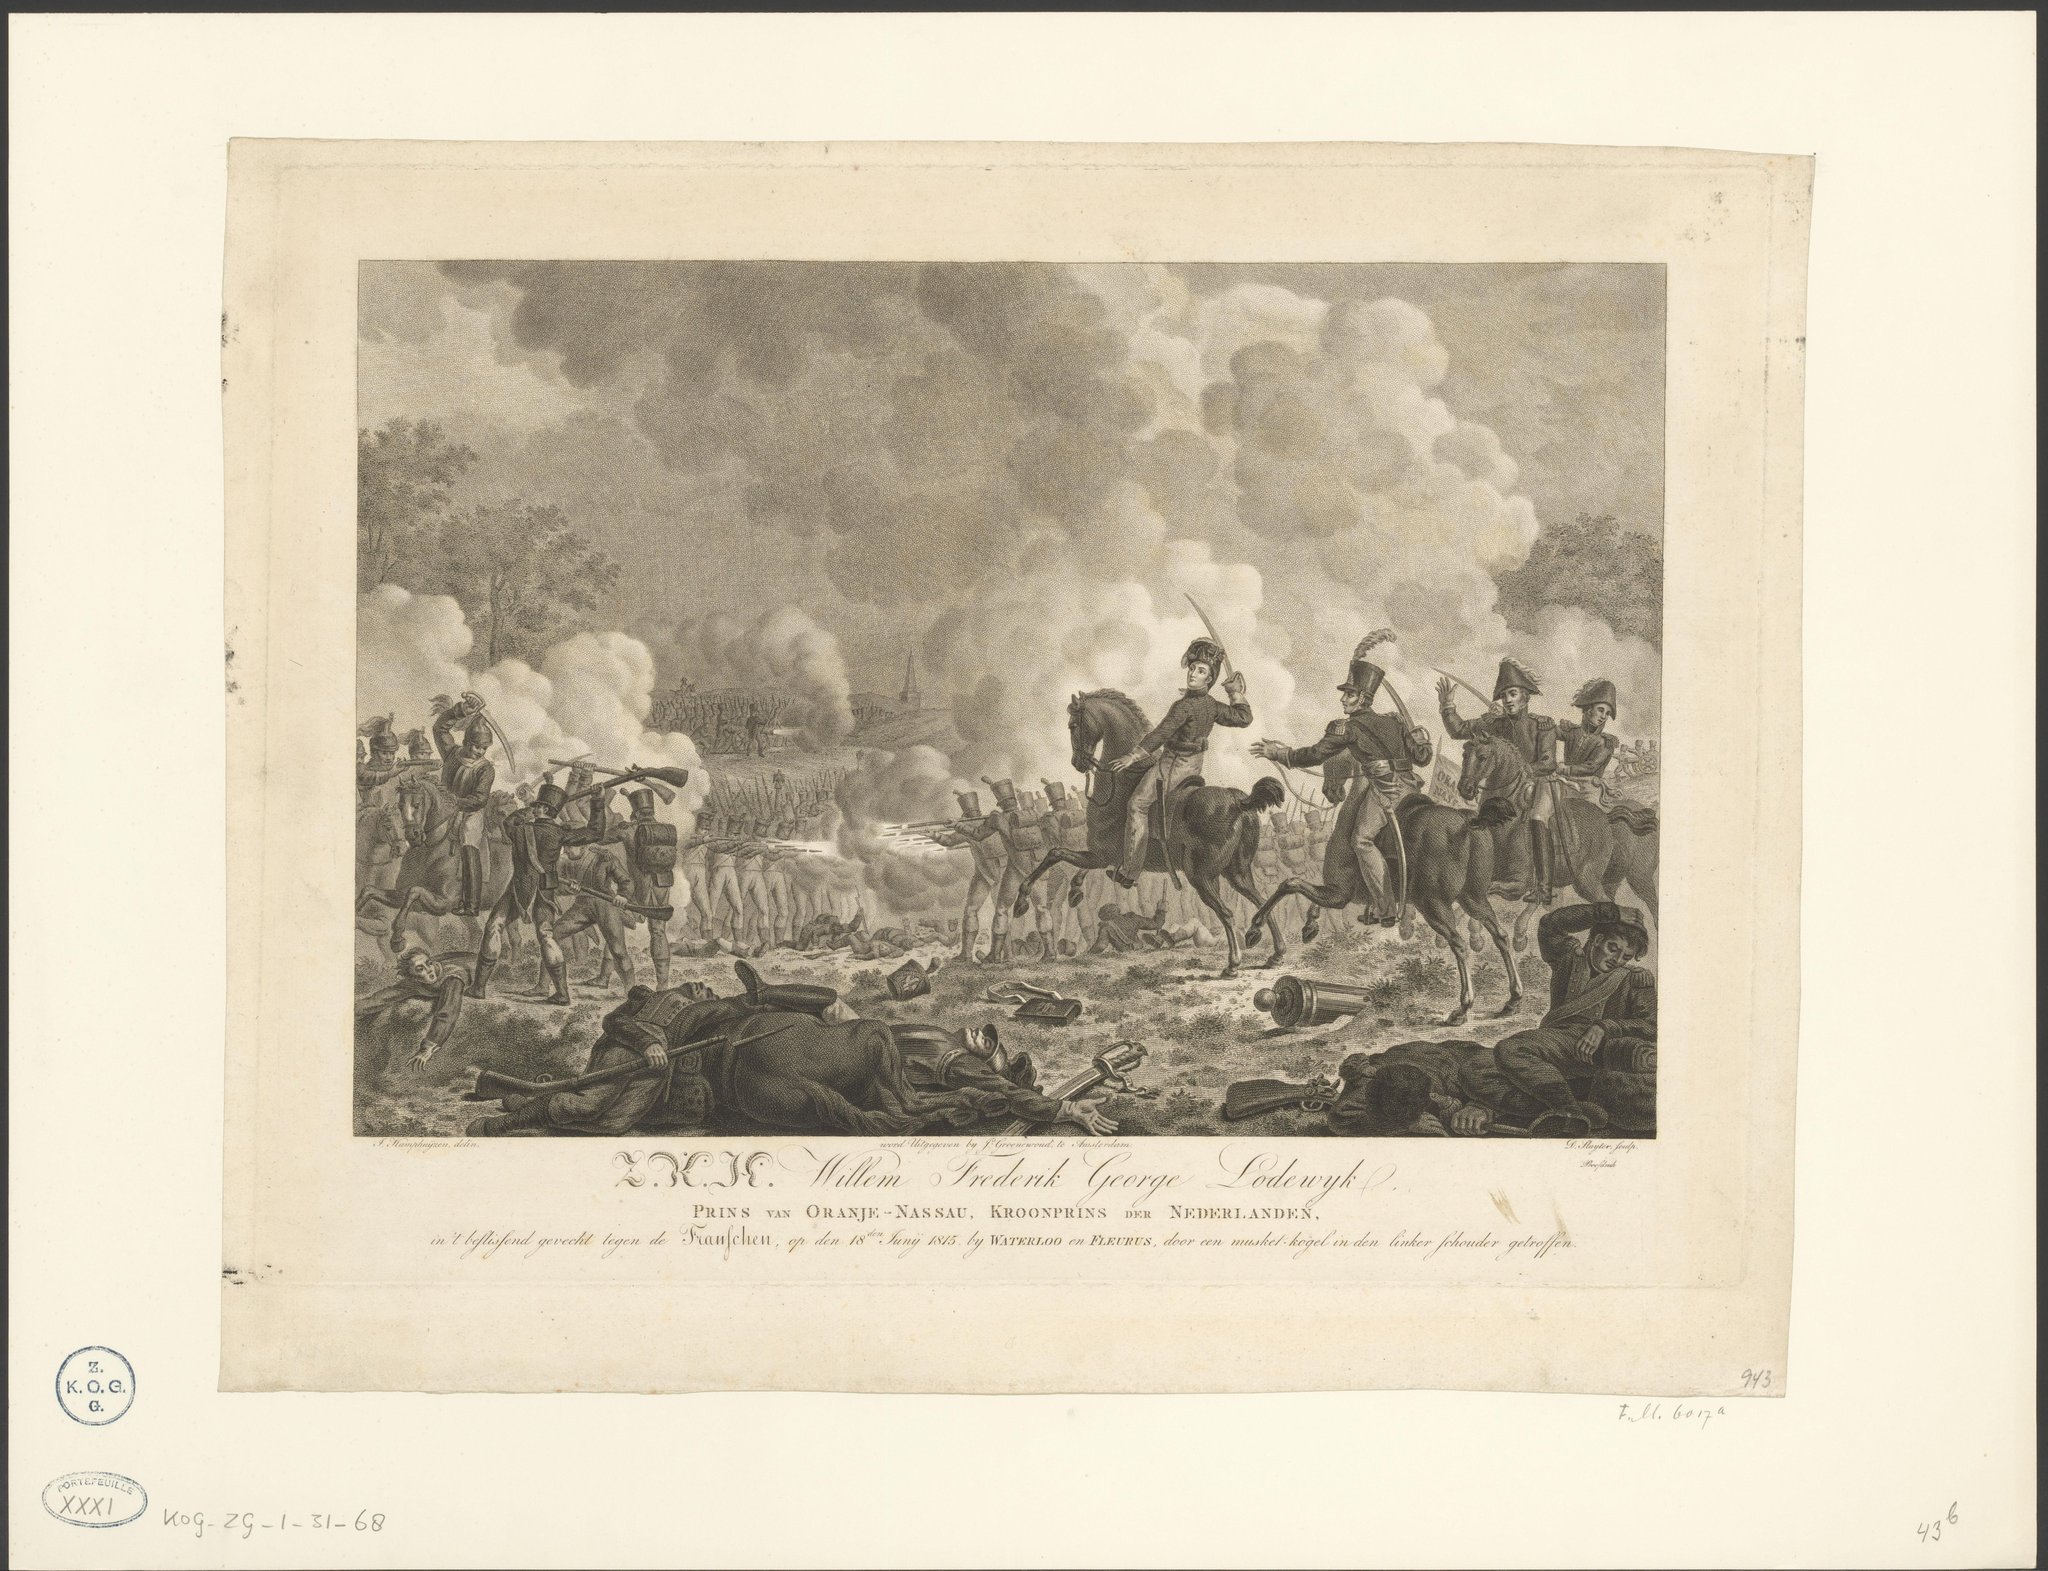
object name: print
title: Z.K.H. Willem Frederik George Lodewijk, Prins van Oranje-Nassau, Kroonprins der Nederlanden (...)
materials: paper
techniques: engraving, etching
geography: amsterdam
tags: the hague, william ii of the netherlands, battle, fighting in general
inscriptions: stamp, collector's mark: Lugt 1641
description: Kroonprins Willem Frederik George Lodewijk, de latere koning Willem II, trekt ten strijde op het slagveld bij Waterloo op 18 juni 1815. Hij raakt daarbij gewond aan zijn schouder door een kogel. Onderwerpsrubrieken binnen de Atlas Zeden en Gewoonten: Portretten, Portretten van Vorsten uit het huis van Oranje, Regeerende Vorsten, Koningen uit het huis van Oranje.